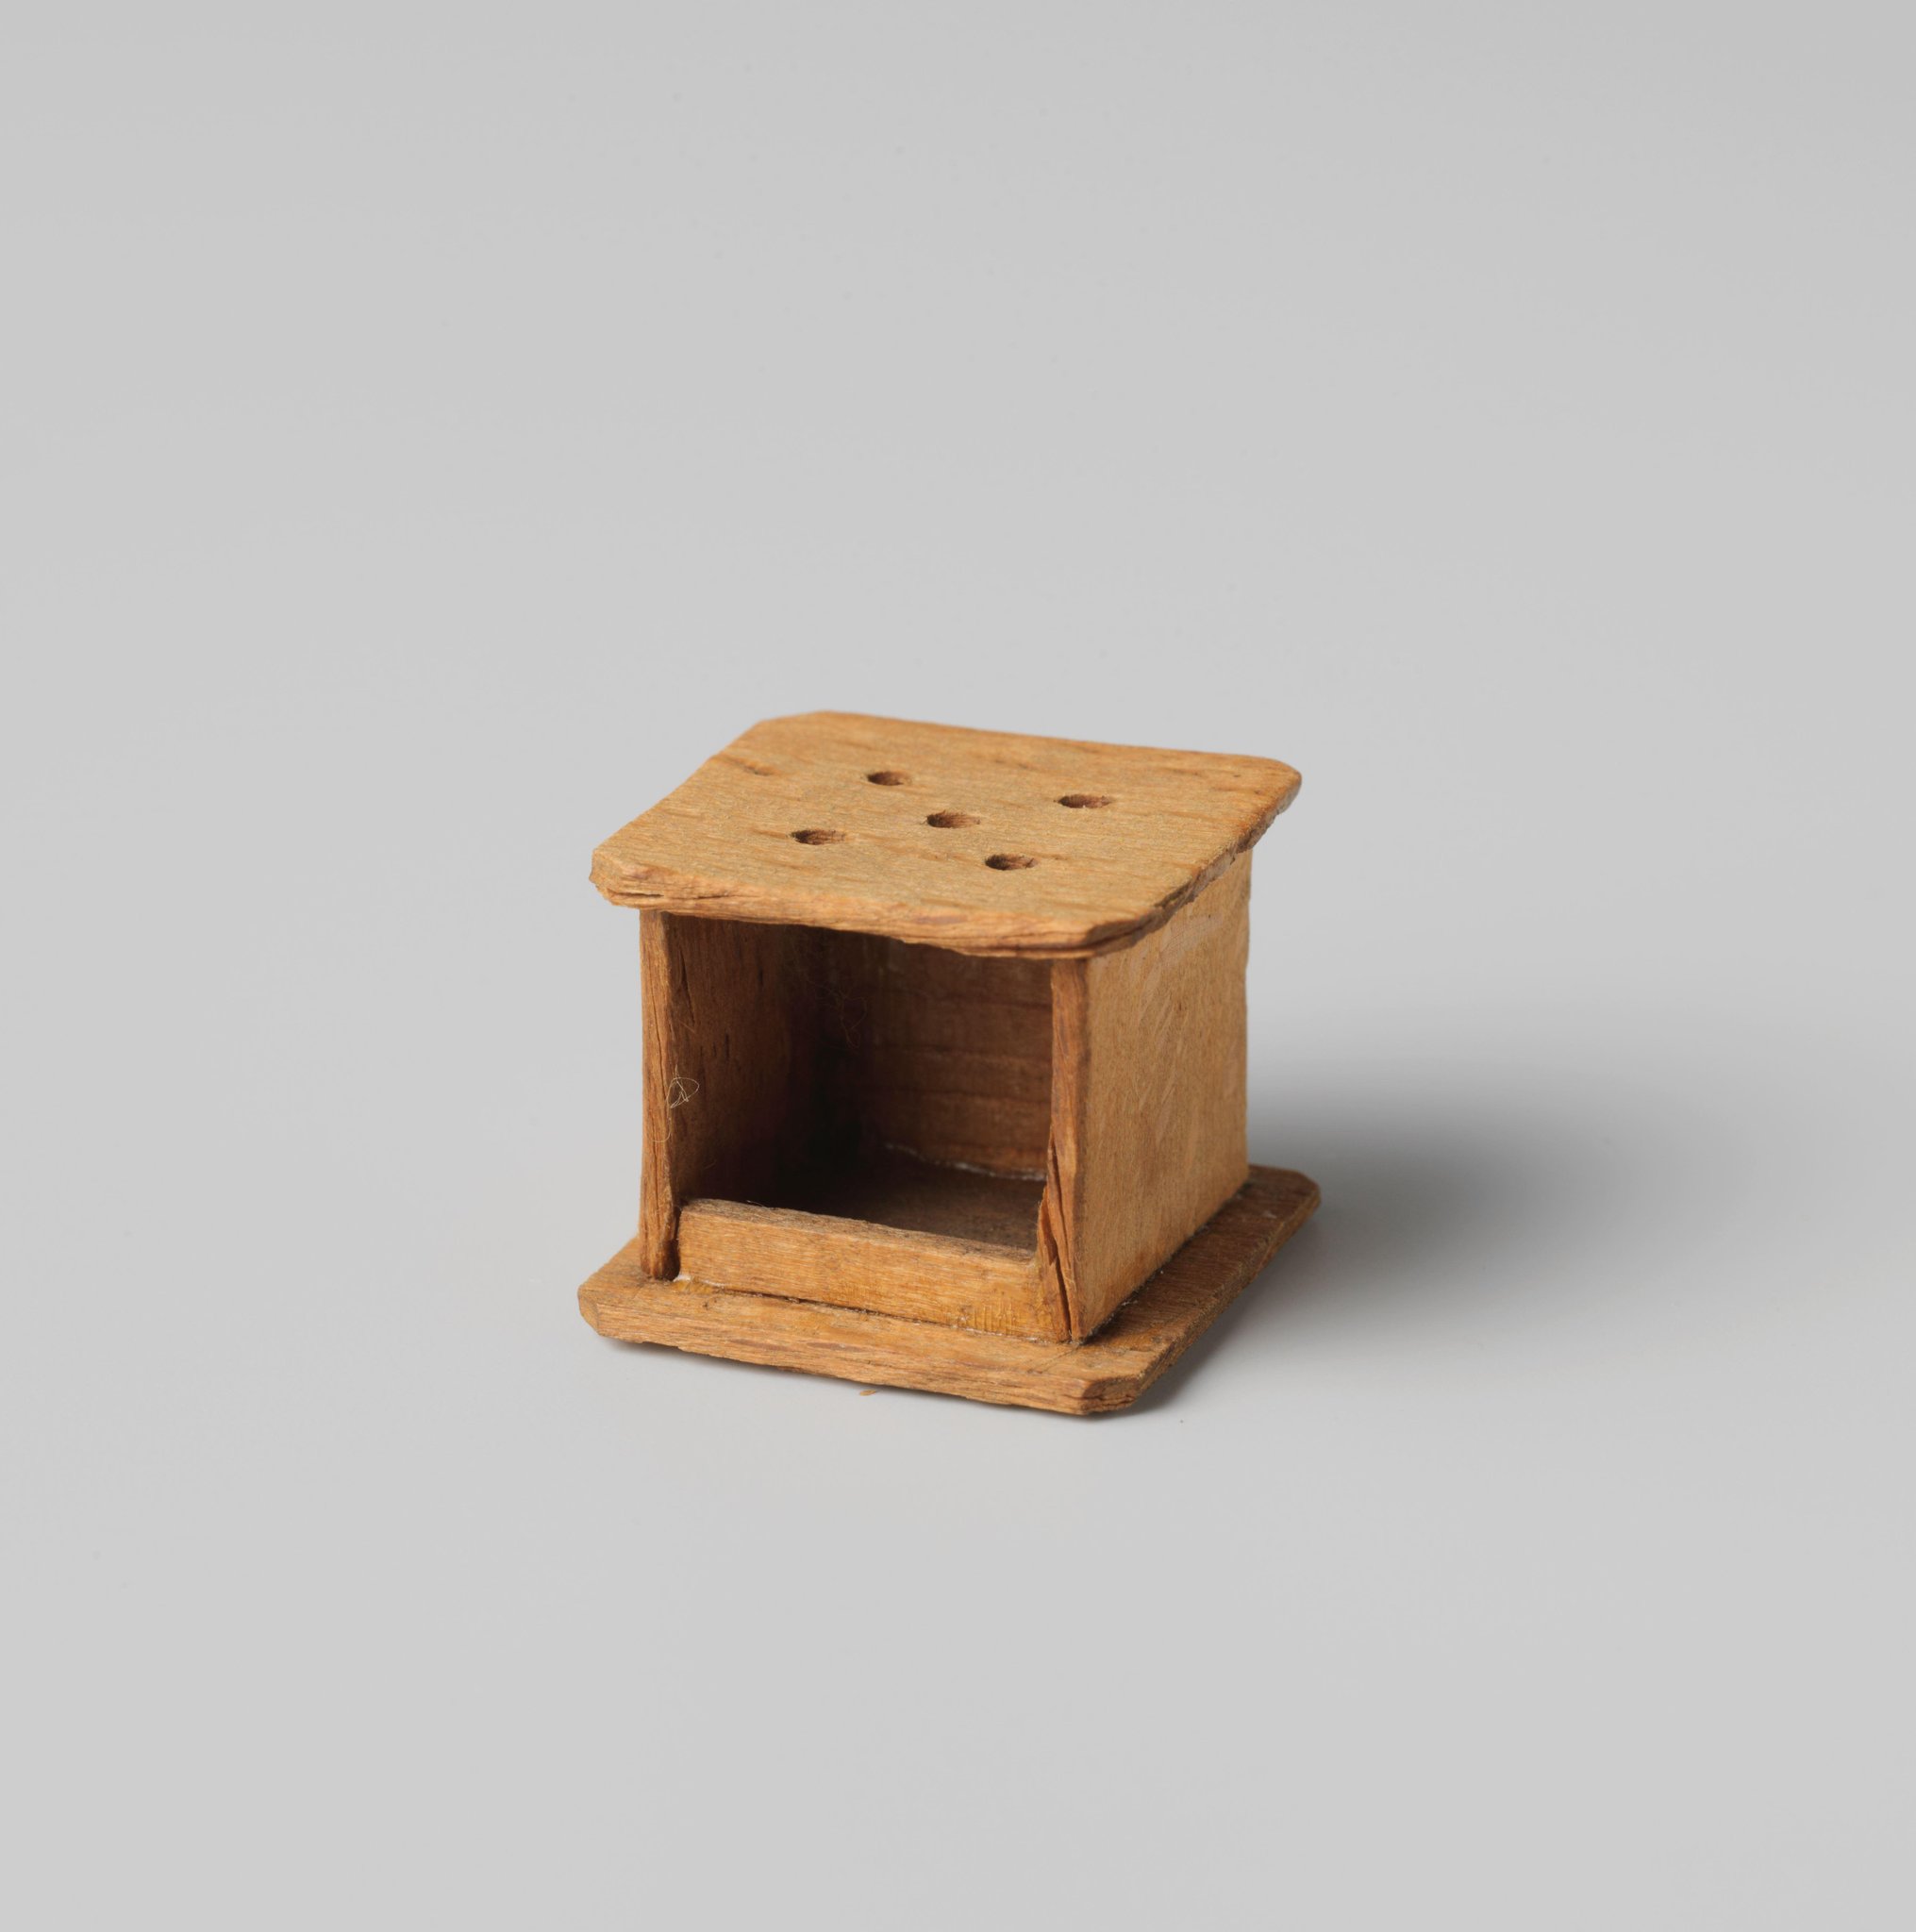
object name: furniture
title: Stoof, rechthoekig, met vijf gaten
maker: Anonymous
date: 1750-1800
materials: wood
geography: amsterdam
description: Stoof van beukenhout, rechthoekig, met vijf gaten in de bovenzijde; de achterzijde van grenenhout.